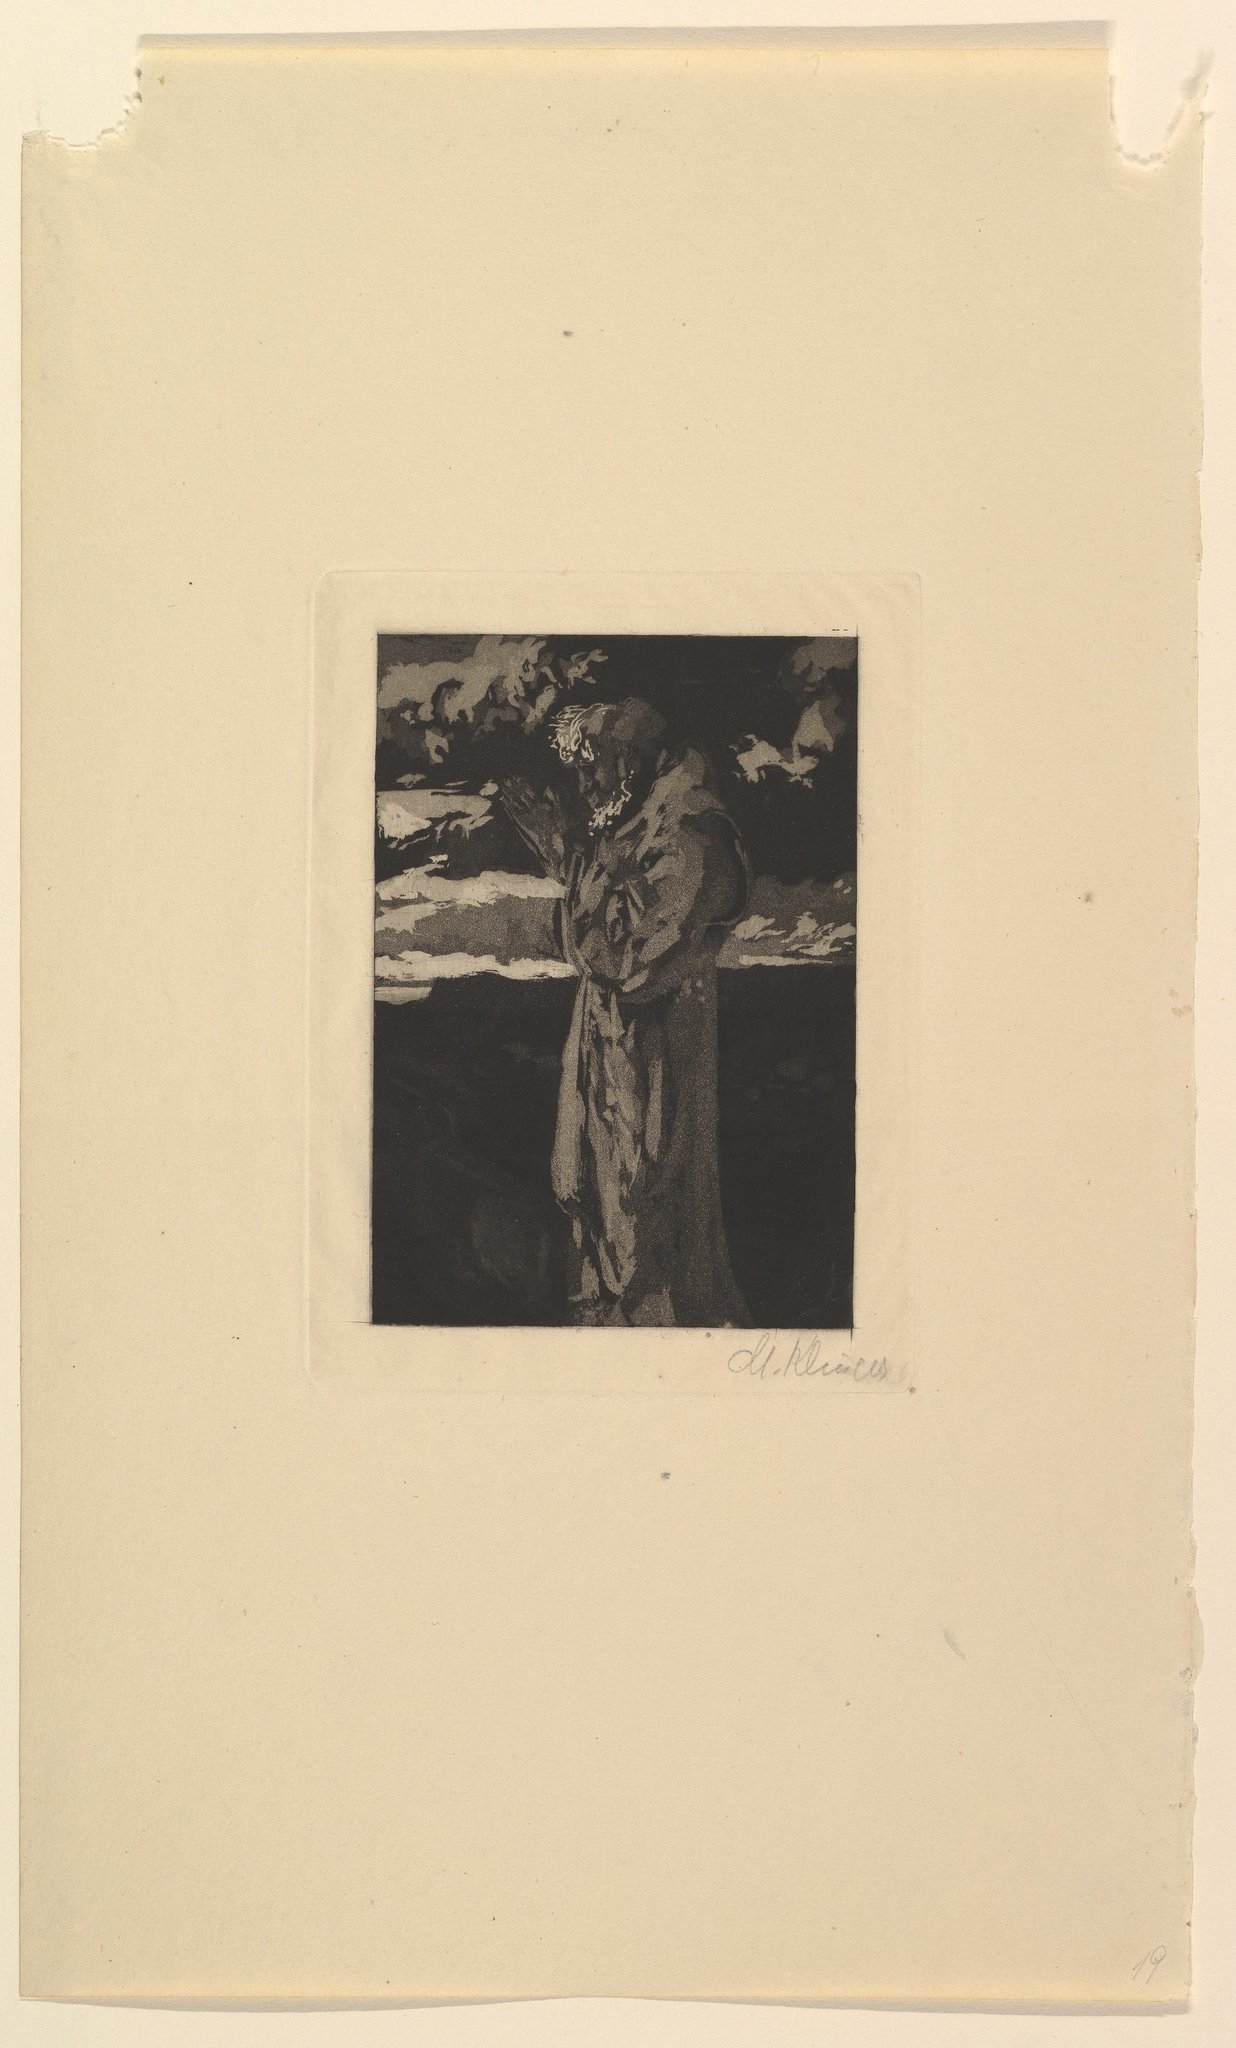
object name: print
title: Old Man Praying (St. Anthony)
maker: max klinger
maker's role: artist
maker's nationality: german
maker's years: 1857-1920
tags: men